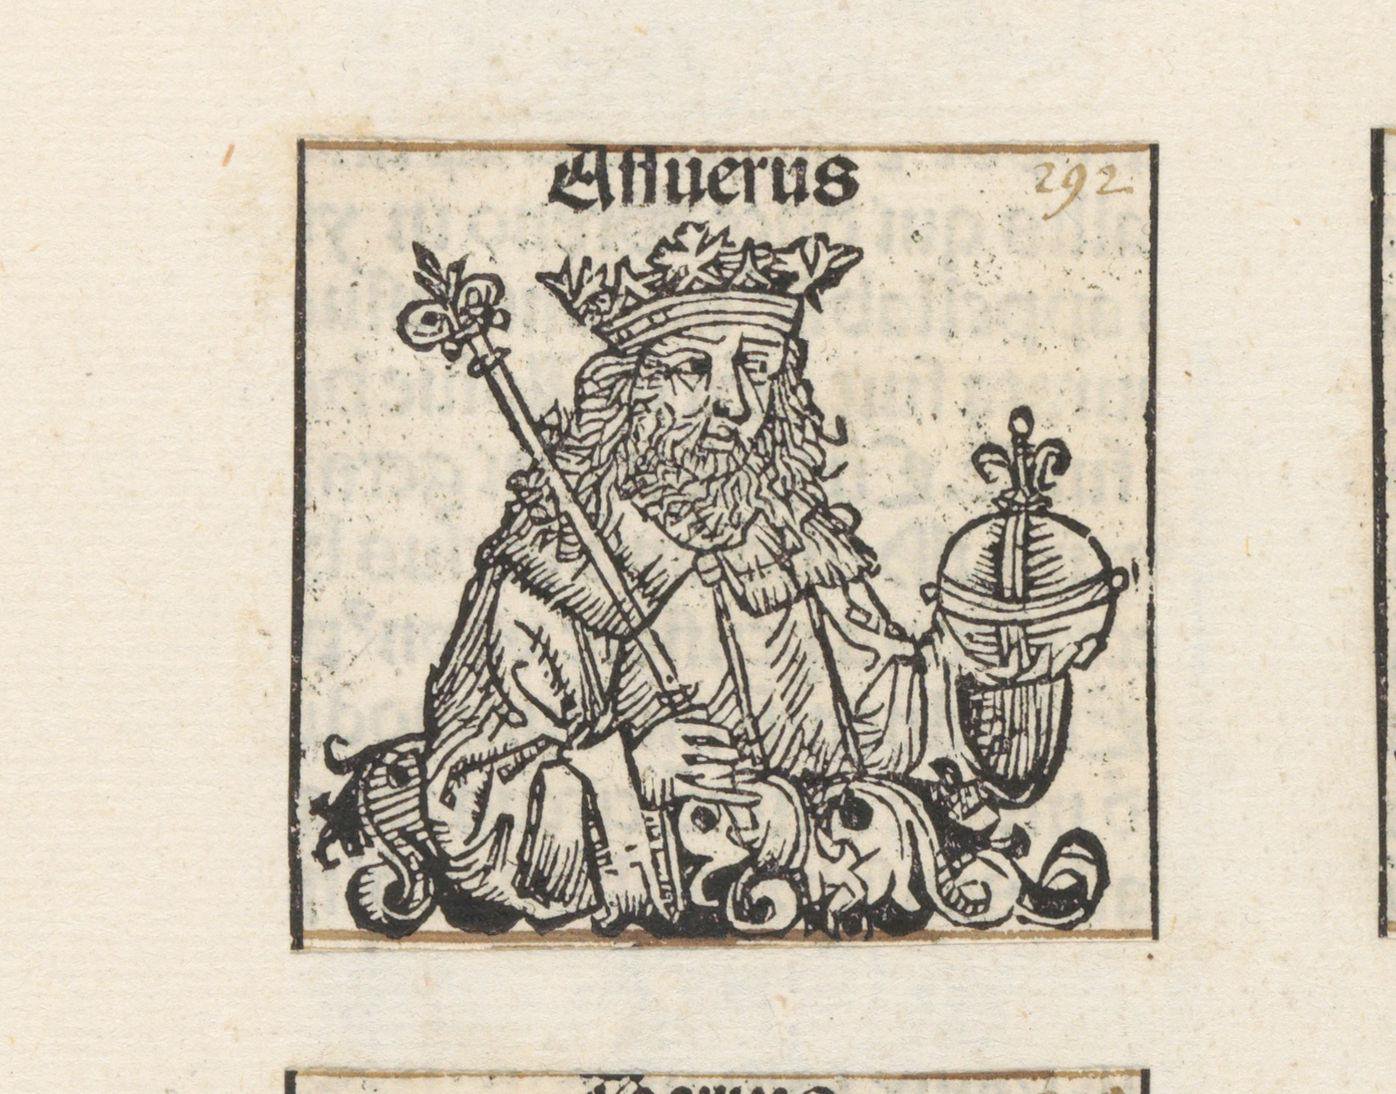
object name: book illustration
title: Koning Artaxerxes II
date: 1493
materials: paper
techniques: letterpress printing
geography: nuremberg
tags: king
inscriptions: inscription: ‘292’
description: Een bloemkelk met een koning, naar rechts gekeerd. In zijn handen heeft hij een scepter en rijksappel. De voorstelling is onderdeel van de opeenvolging Perzische koningen in de Liber Chronicarum. De tekst identificeert de man als Artaxerxes II. De prent maakt deel uit van een album.